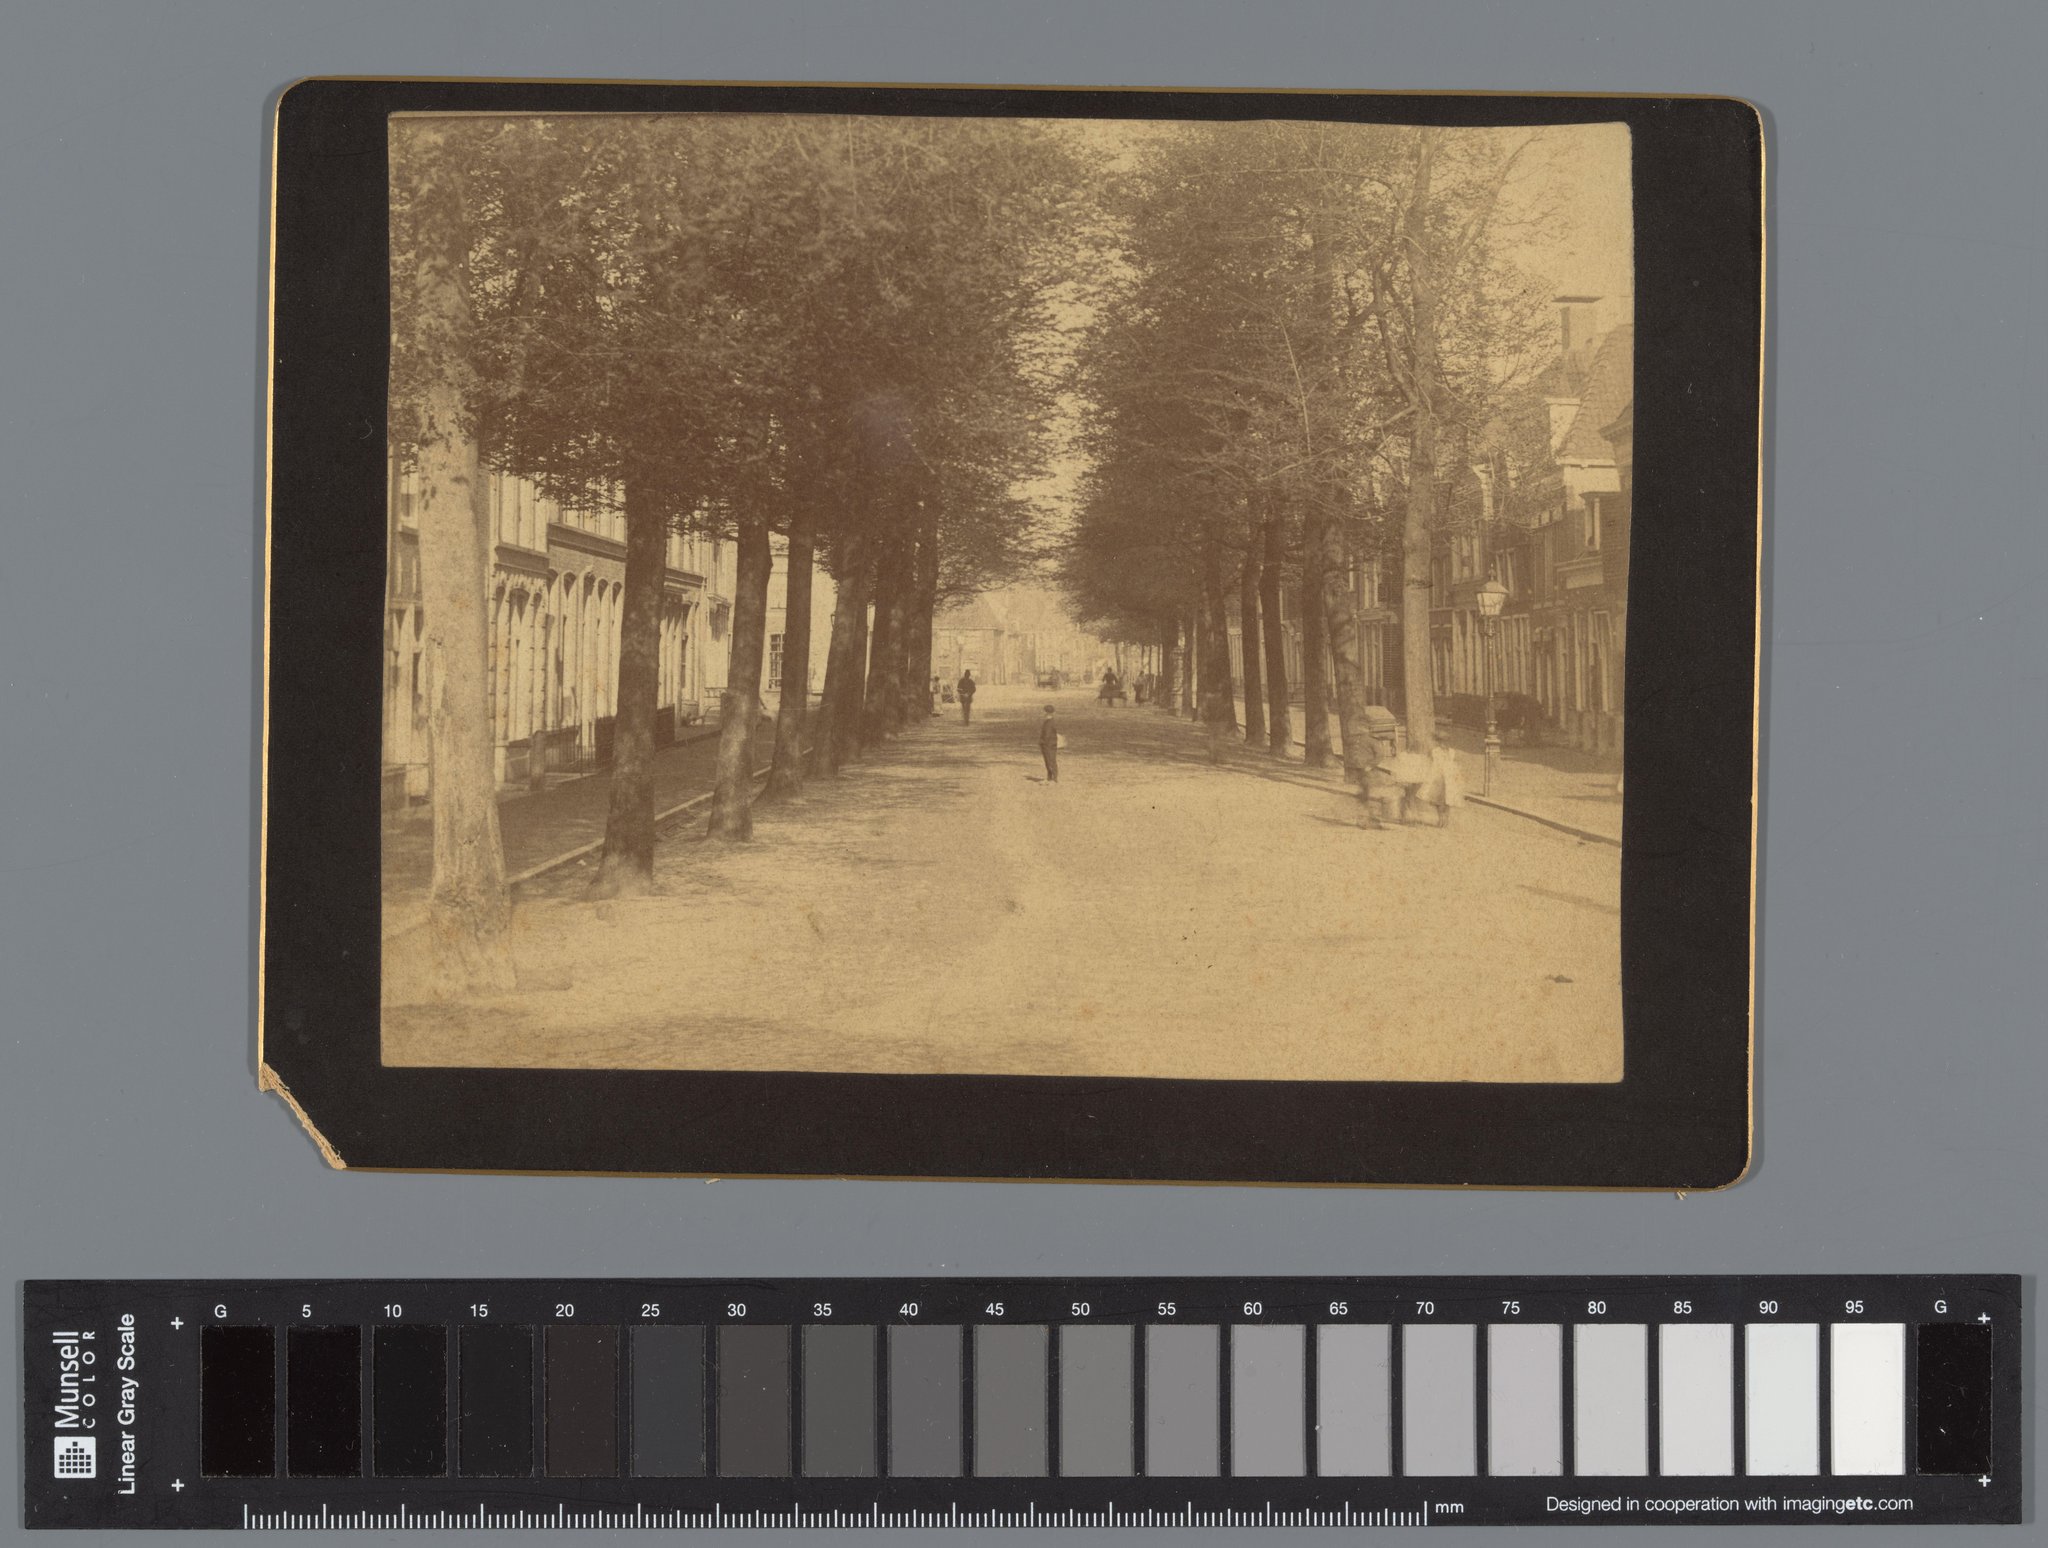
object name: photograph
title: Brede laan met bomen in een stad, Nederland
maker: Anonymous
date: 1860-1900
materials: cardboard, paper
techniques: albumen print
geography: netherlands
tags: street, netherlands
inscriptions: inscription: ‘Ubi’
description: Mogelijk is dit de Hooglandse Kerkgracht te Leiden.